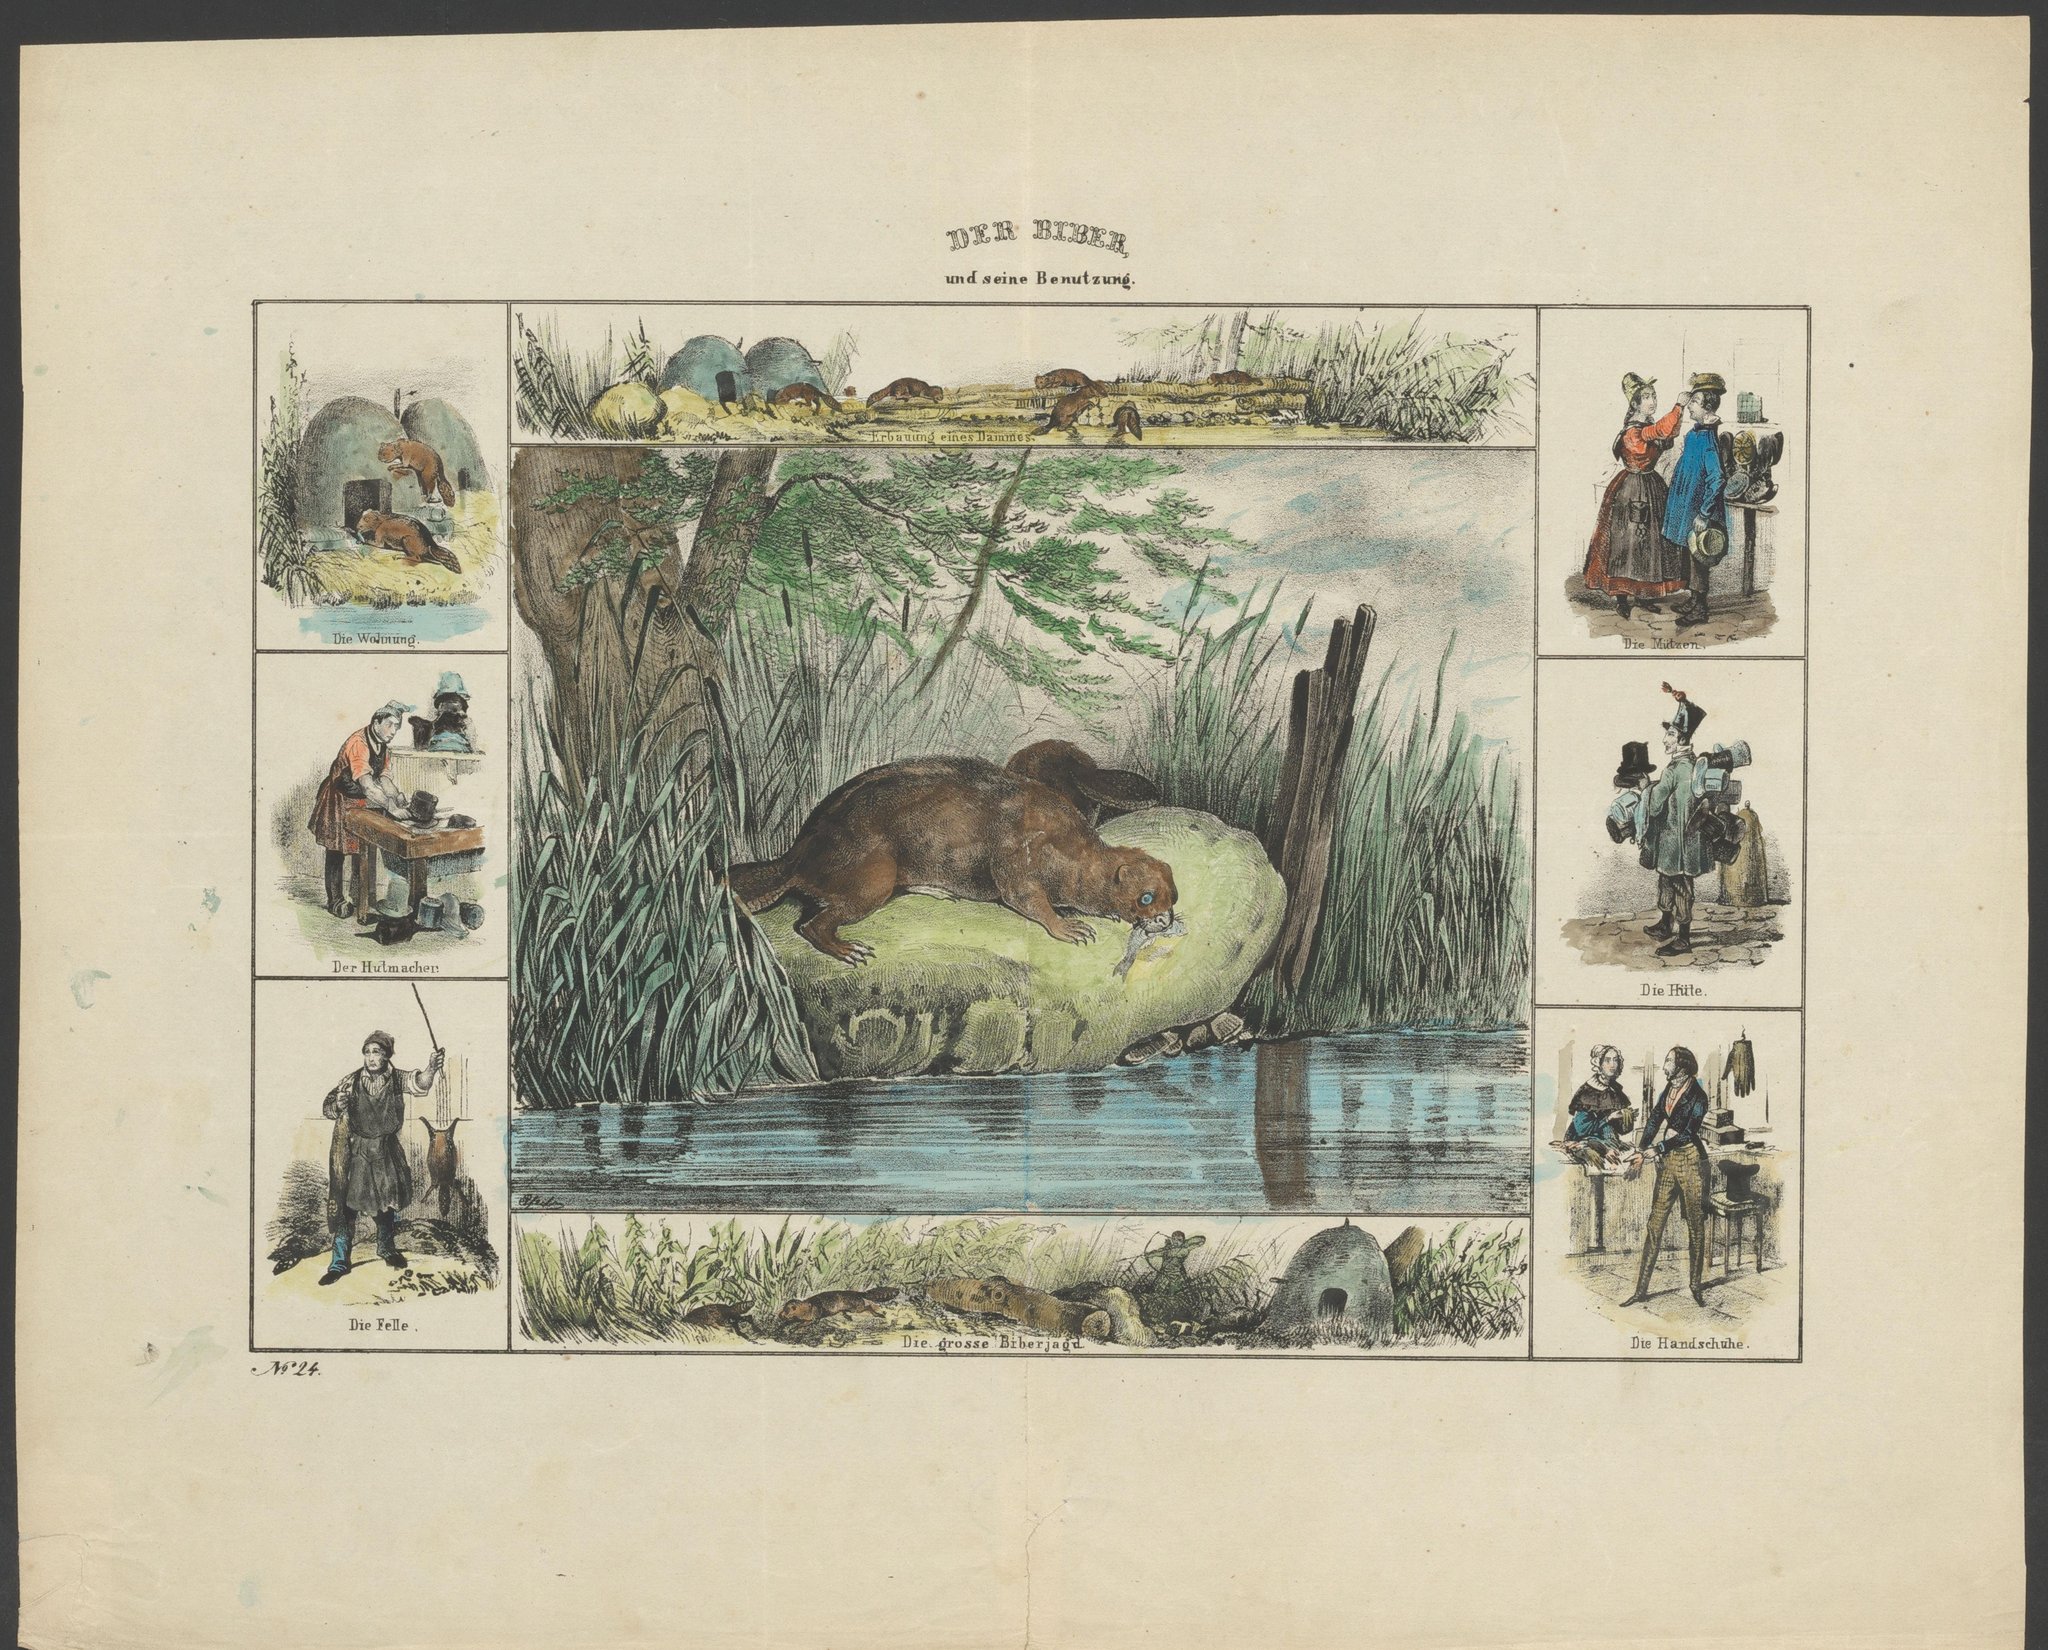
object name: print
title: Bever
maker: Anonymous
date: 1800-1899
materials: paper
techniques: hand coloring, lithograph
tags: rodents: beaver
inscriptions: stamp, collector's mark: Lugt 1641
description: In het midden een bever met een vis in zijn bek. Aan beide zijde drie afbeeldingen van de beverjacht en de verwerking van de huid. Linksonder genummerd: No. 24. Onderwerpsrubrieken binnen de Atlas Zeden en Gewoonten: Zeden en Gewoonten in Engeren Zin, Des menschen beging, midden en einde, Kinderleven – Kinderspel en Kinderprenten.